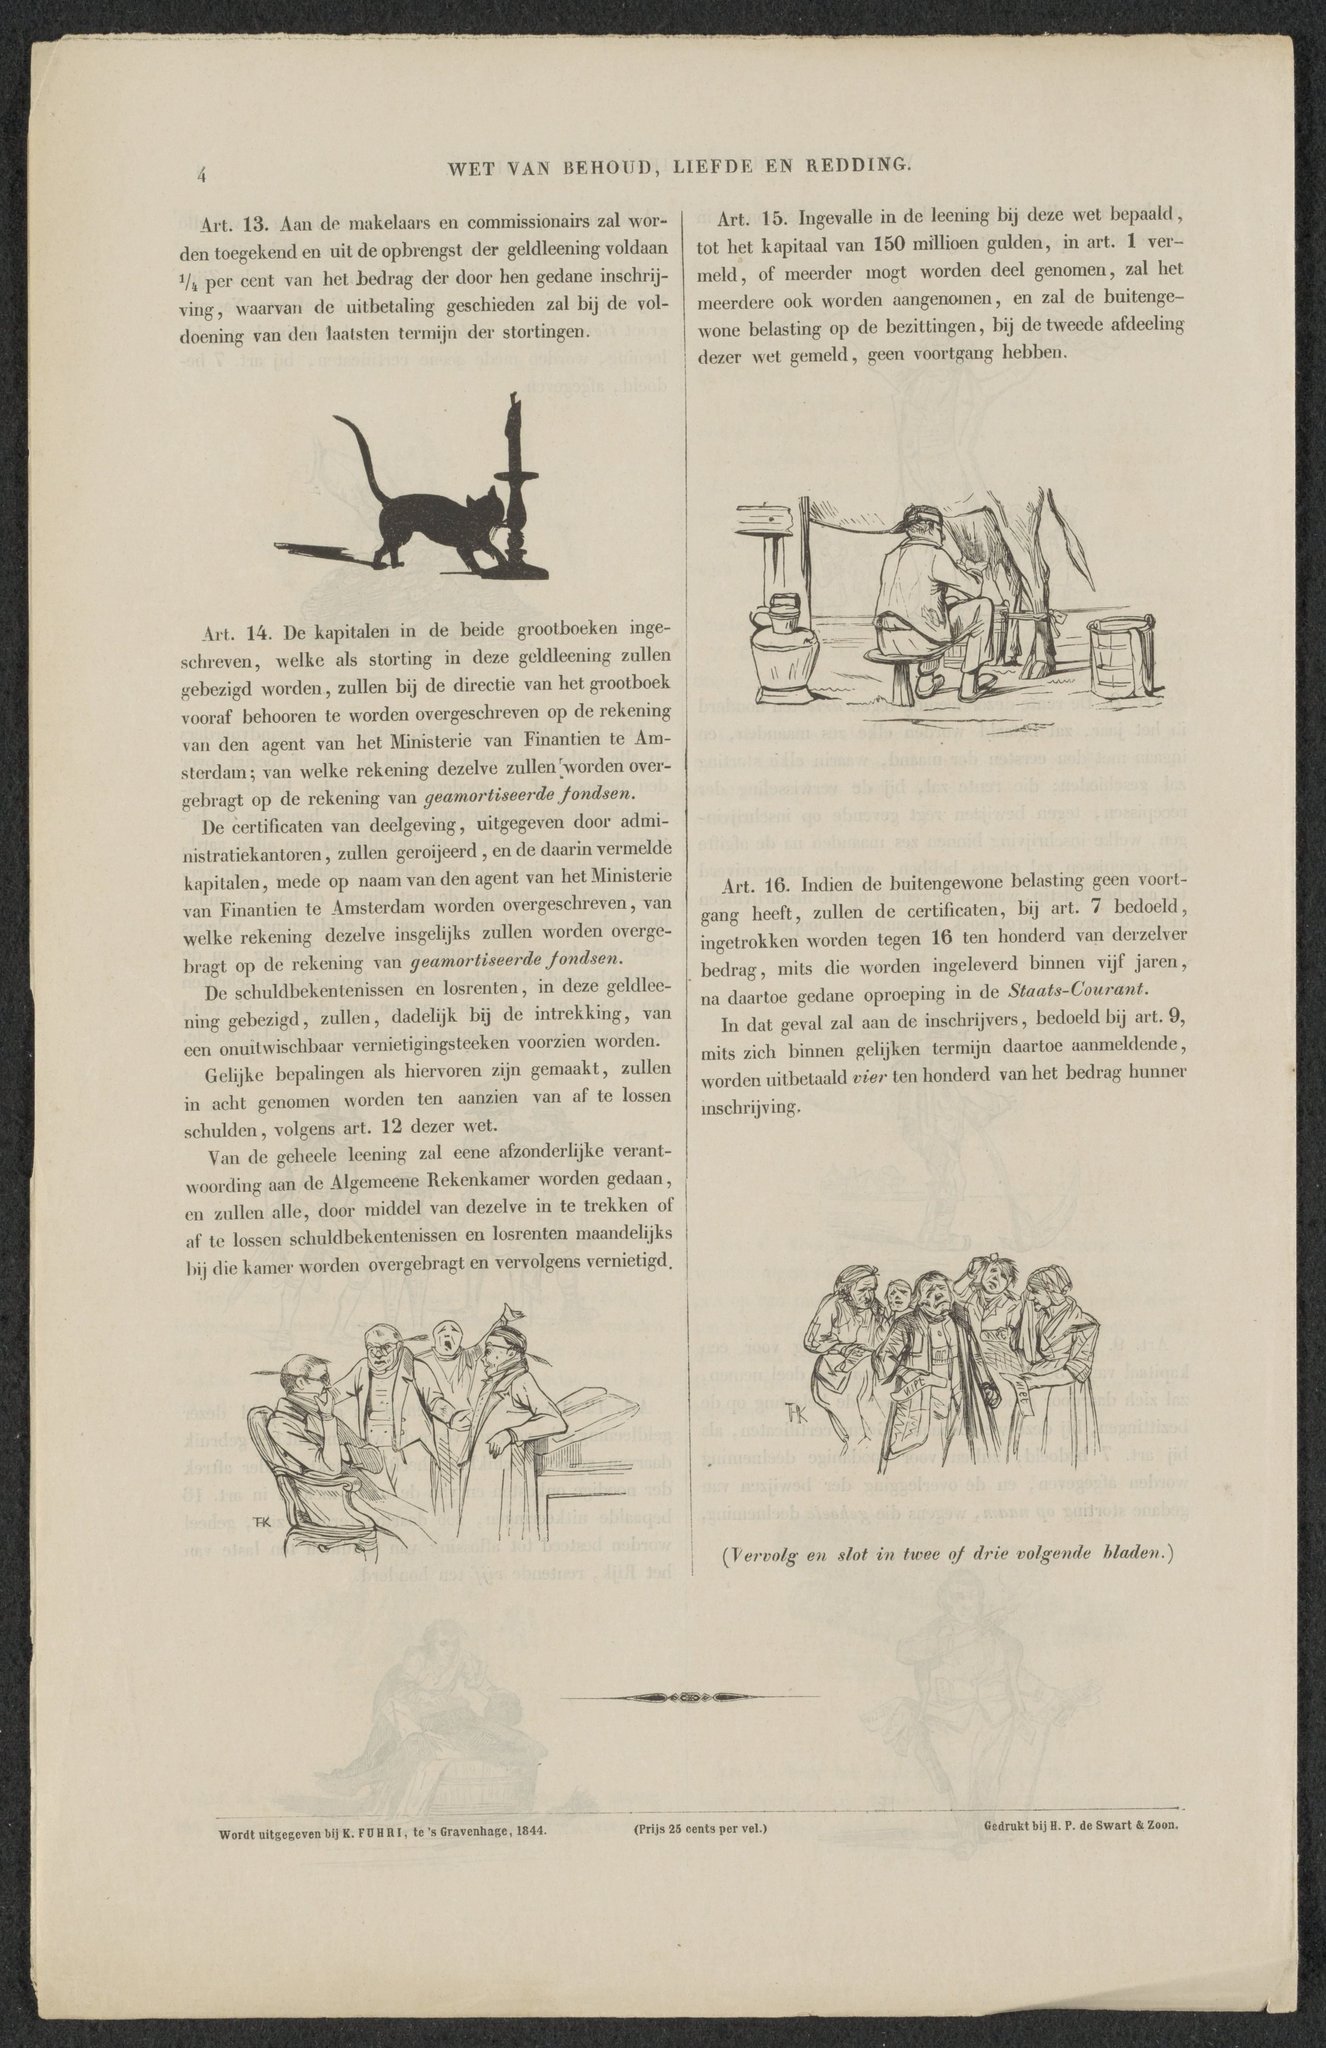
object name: print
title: Satire op de aansporing tot deelneming in de (zogenaamde) vrijwillige 3% geldlening van 1844 (blad 4)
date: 1844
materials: paper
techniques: letterpress printing, engraving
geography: netherlands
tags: amsterdam, the hague, floris adriaan van hall, organization of trade and finance, taxes and financial administration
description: Bladzijde 4 met artikels 13-16 van de 'Wet van Behoud, Liefde en Redding'. Een satire in zestien bladzijden op de aansporing tot deelneming in de (zogenaamde) vrijwillige 3% geldlening uitgeschreven in maart 1844 door minister F. A. van Hall. Achterzijde van een dubbelgevouwen blad bedrukt op alle zijden.